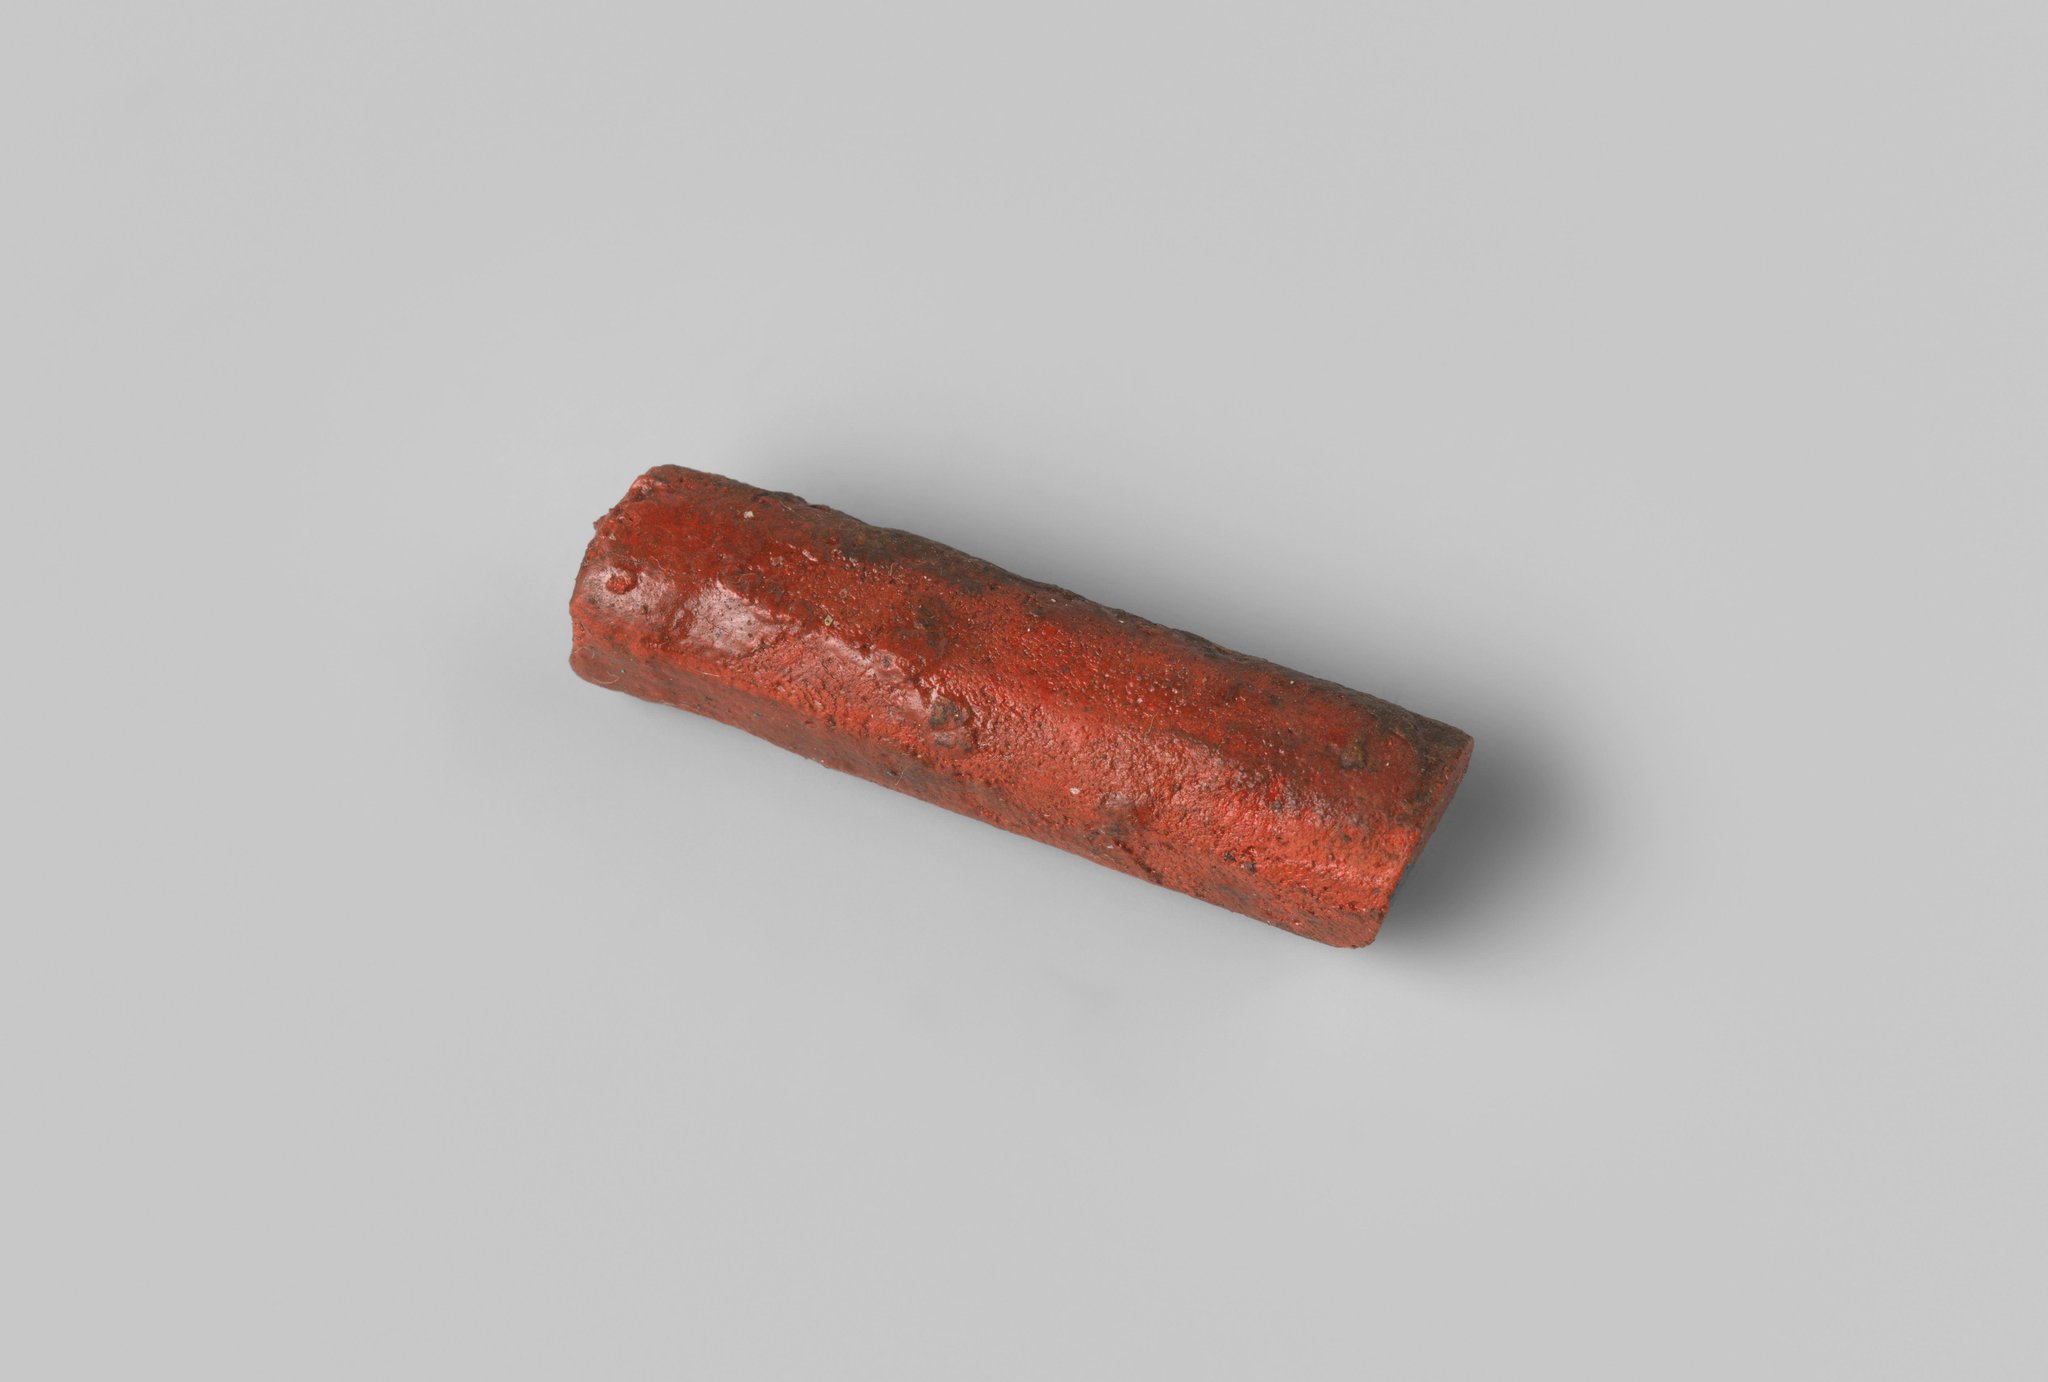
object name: sealing wax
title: Zegellak uit het wrak van de Oost-Indiëvaarder Hollandia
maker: Anonymous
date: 1700-1743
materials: wax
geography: netherlands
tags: verenigde oostindische compagnie, hollandia (schip), annet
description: Marking and proving, sealing wax, red; fragm, id. NG 1980-27H2020, both ends broken.